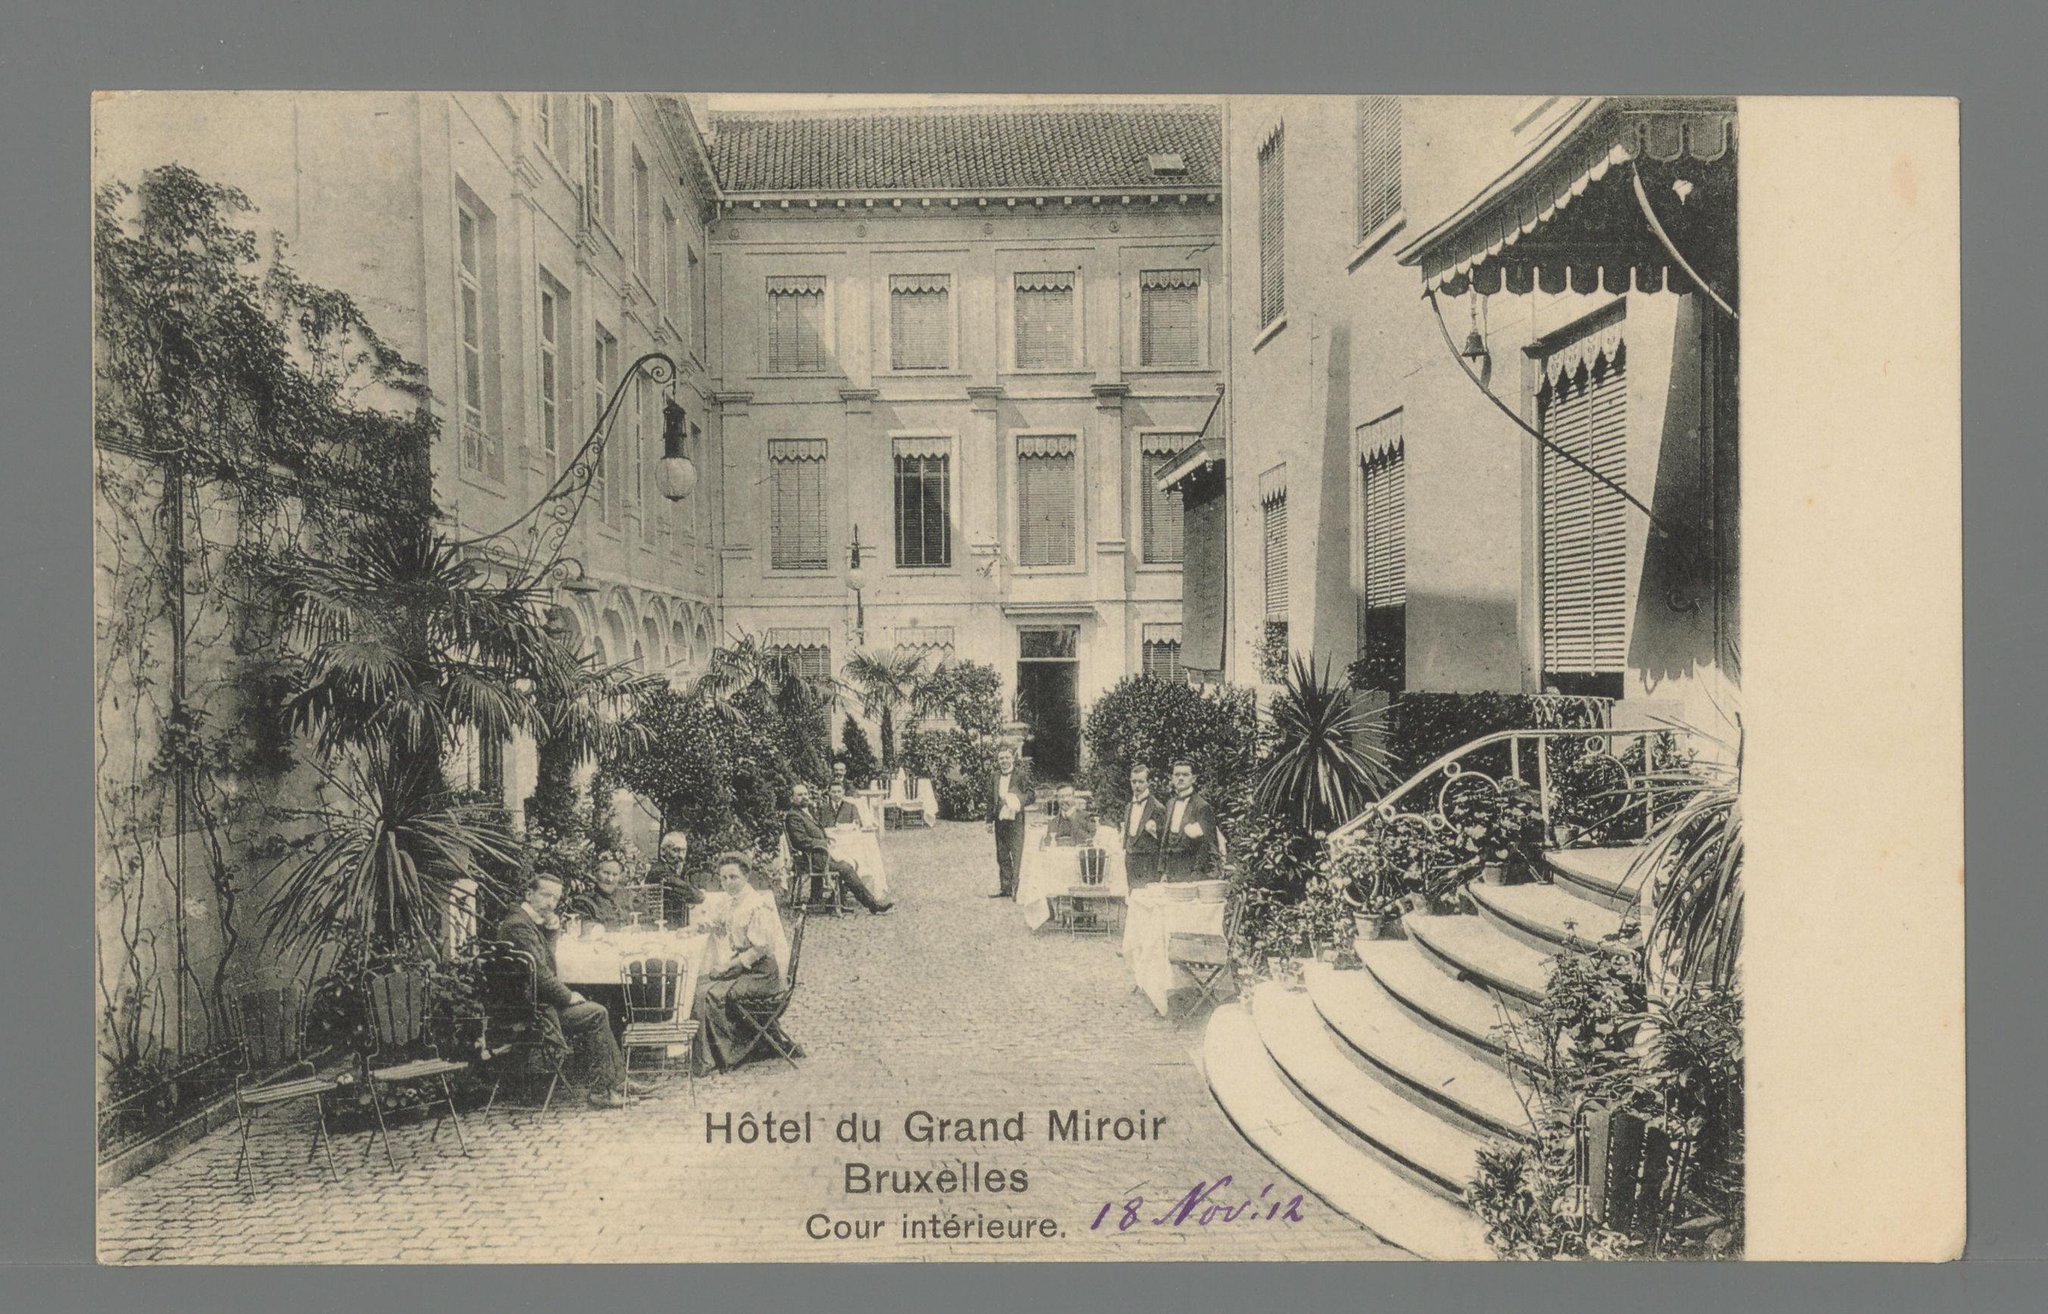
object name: ansichtkaart, prentbriefkaart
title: Hôtel du Grand Miroir. Bruxelles. Cour intérieure.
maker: Anonymous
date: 1907-1912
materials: cardboard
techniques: photograph, writing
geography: brussels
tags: open-air recreation, courtyard, hotel, hostelry, inn, brussels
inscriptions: postage stamp